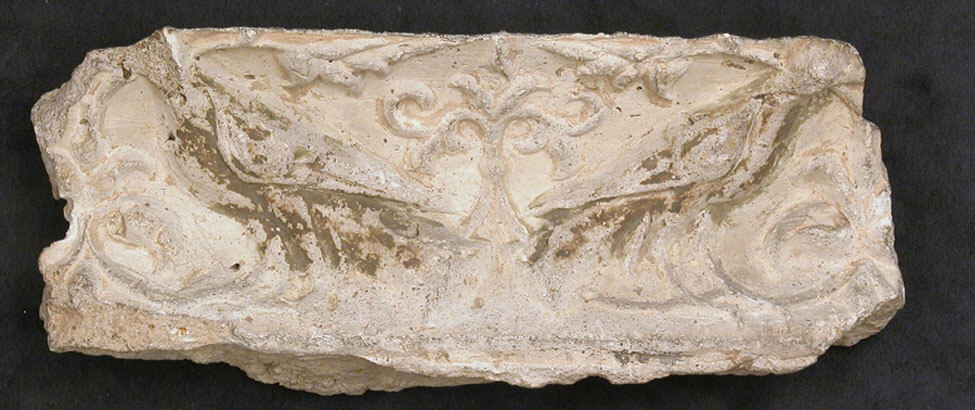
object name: frieze fragment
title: Fragment of a Frieze with Addorsed Birds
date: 1101-1200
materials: gypsum, plaster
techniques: molding, painting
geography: iran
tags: birds